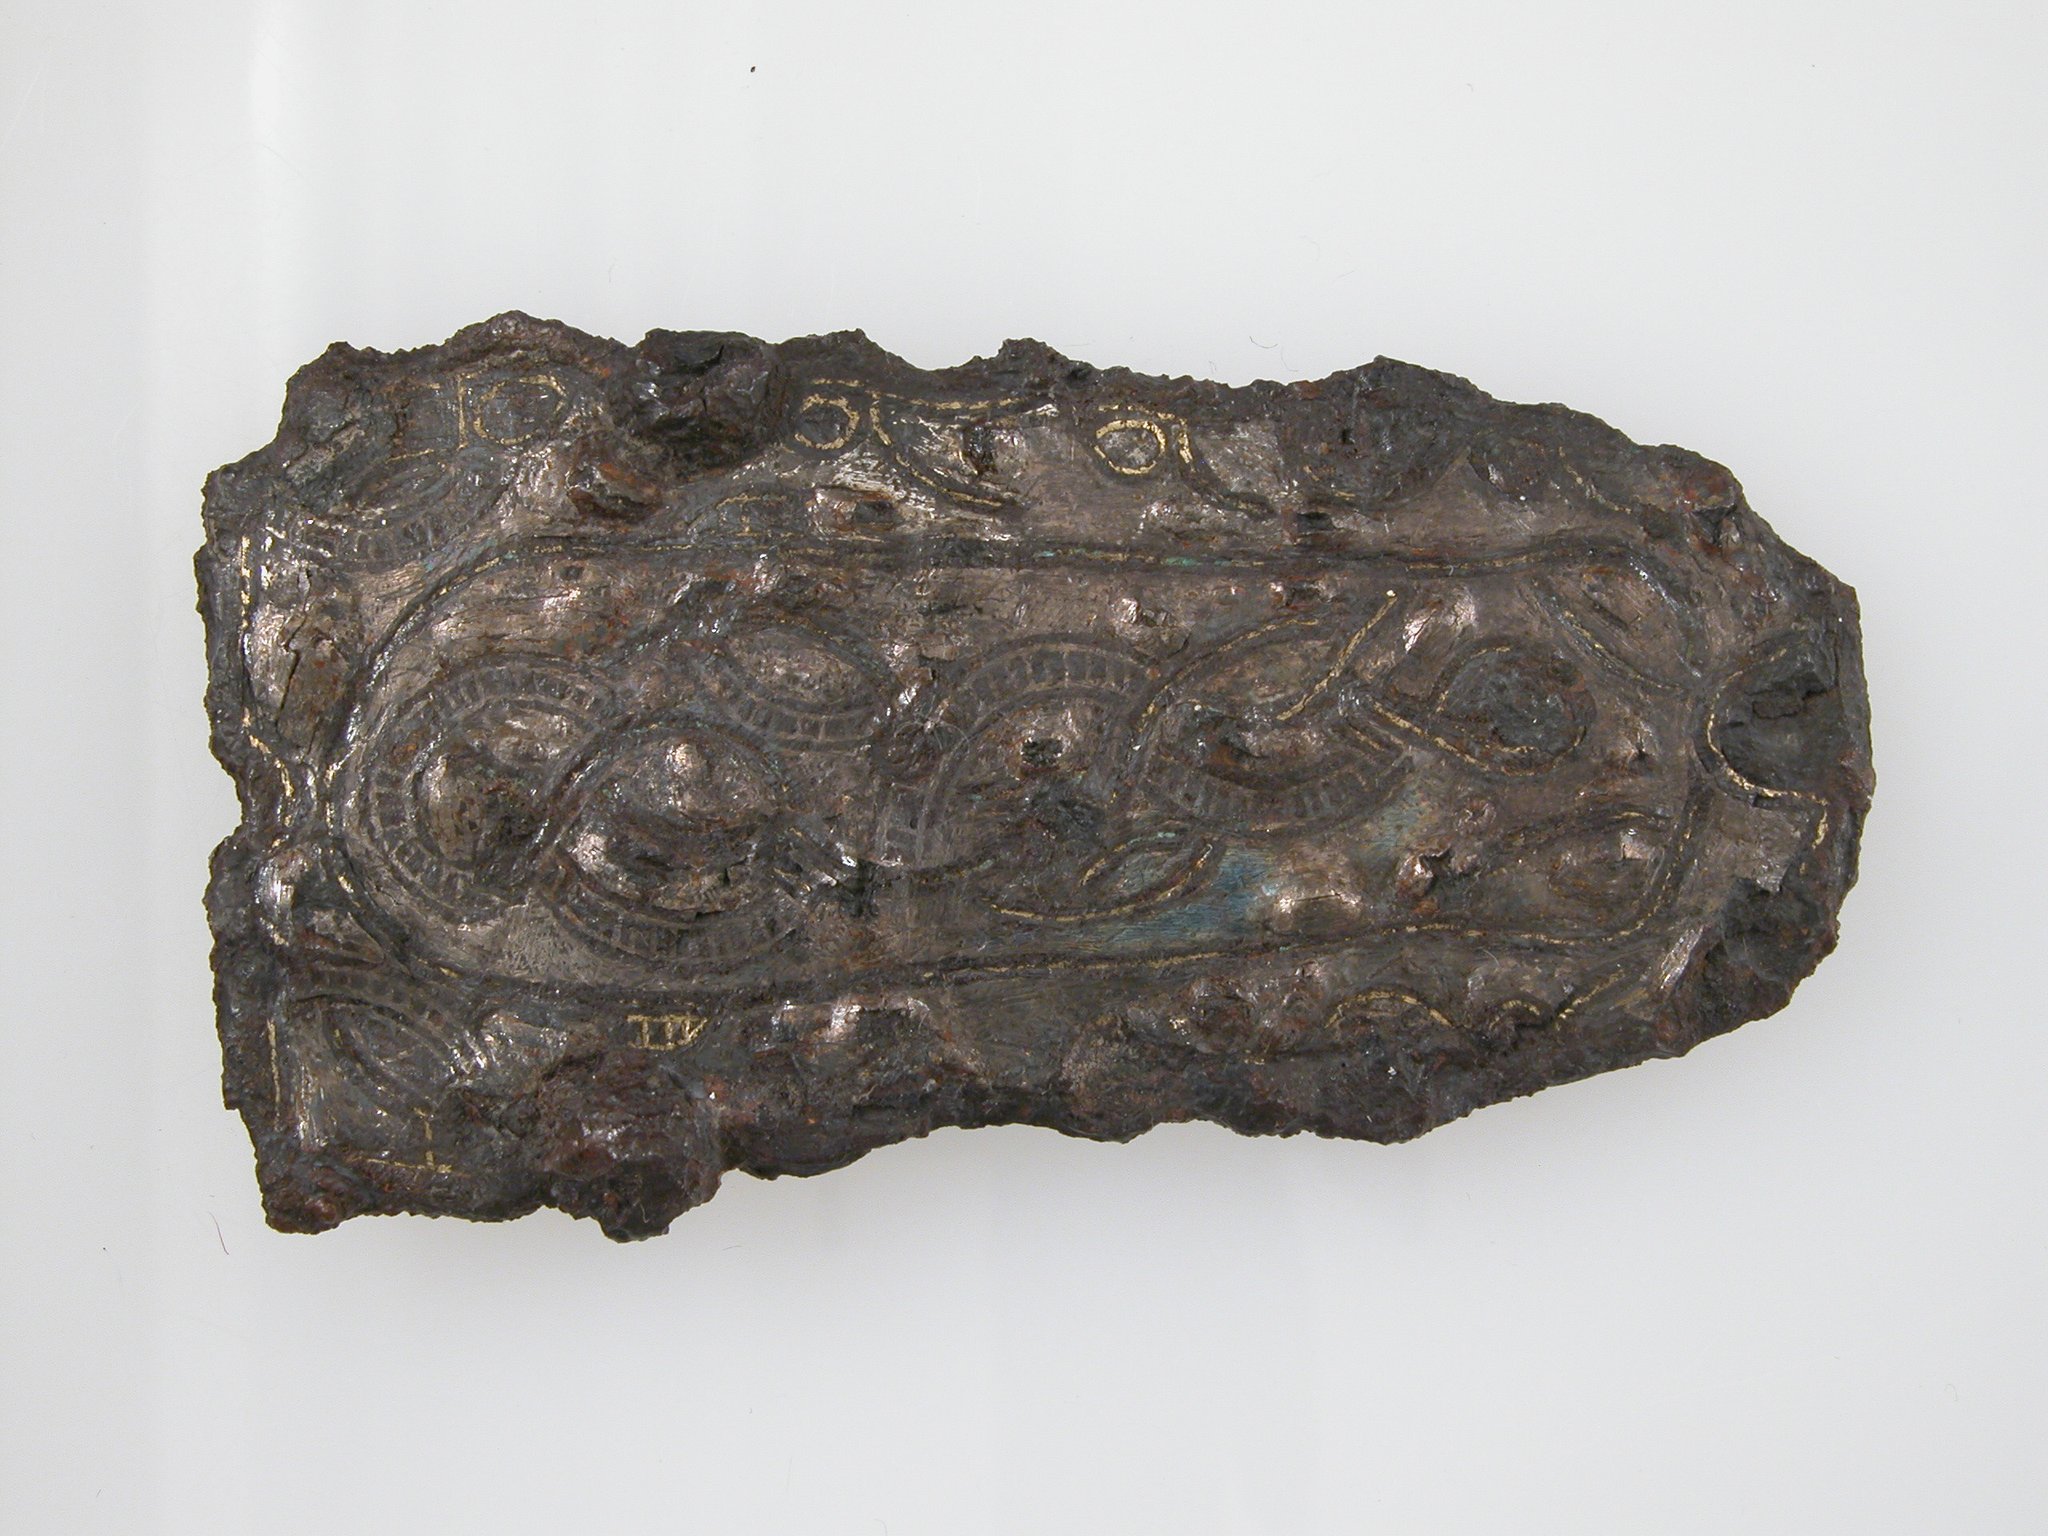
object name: belt plate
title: Belt Buckle Plate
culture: frankish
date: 501-700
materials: copper alloy, iron, silver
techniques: inlay